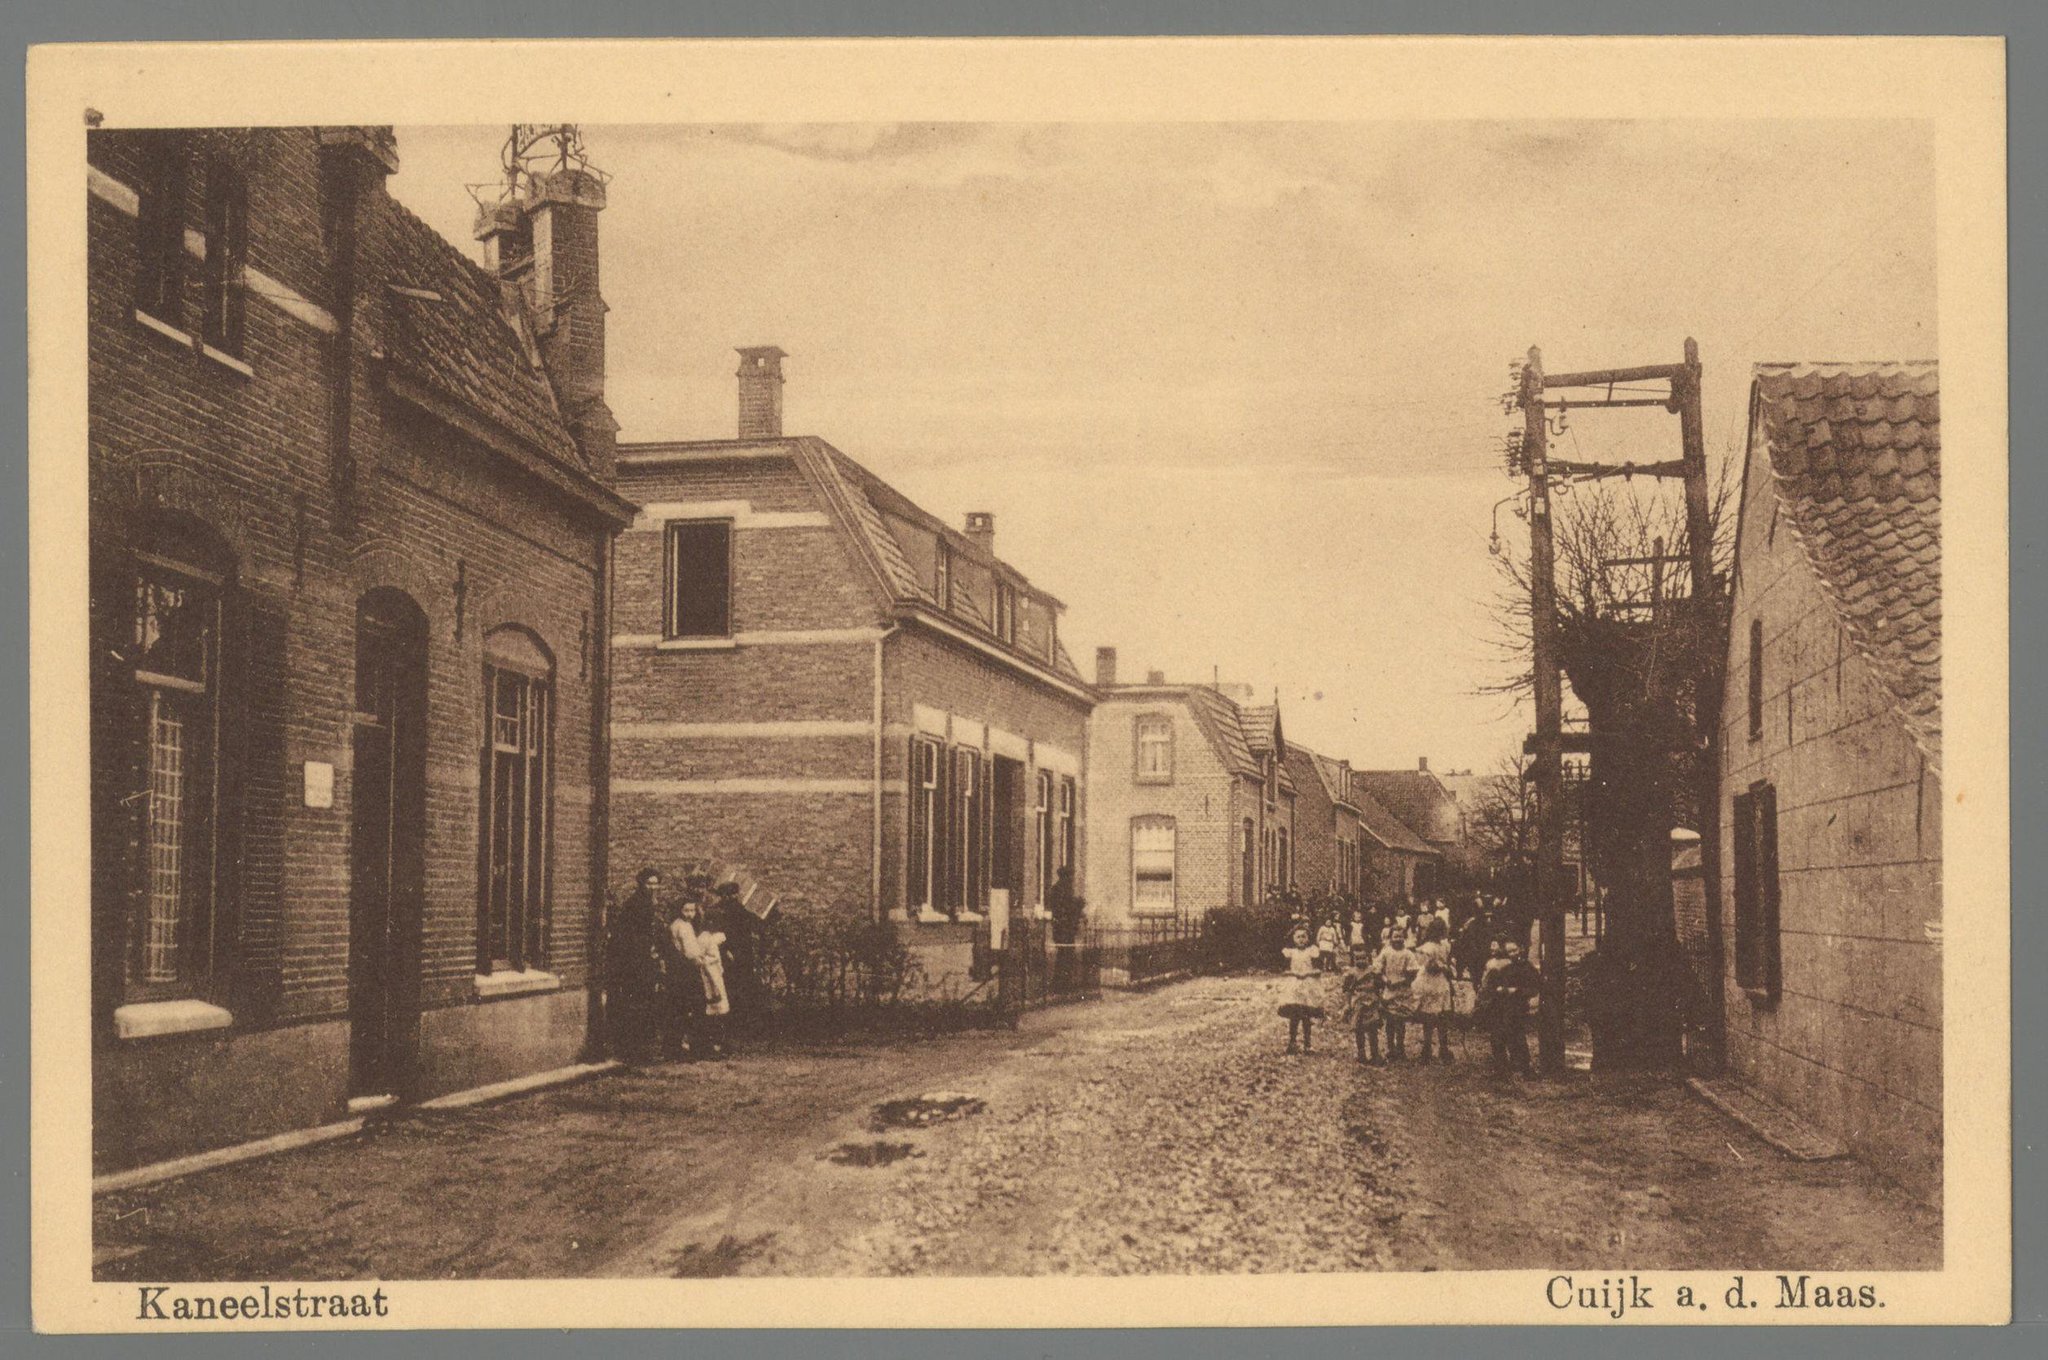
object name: ansichtkaart, prentbriefkaart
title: Kaneelstraat. Cuijk a.d. Maas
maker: Anonymous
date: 1913-1950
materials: cardboard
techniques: photograph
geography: cuijk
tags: street